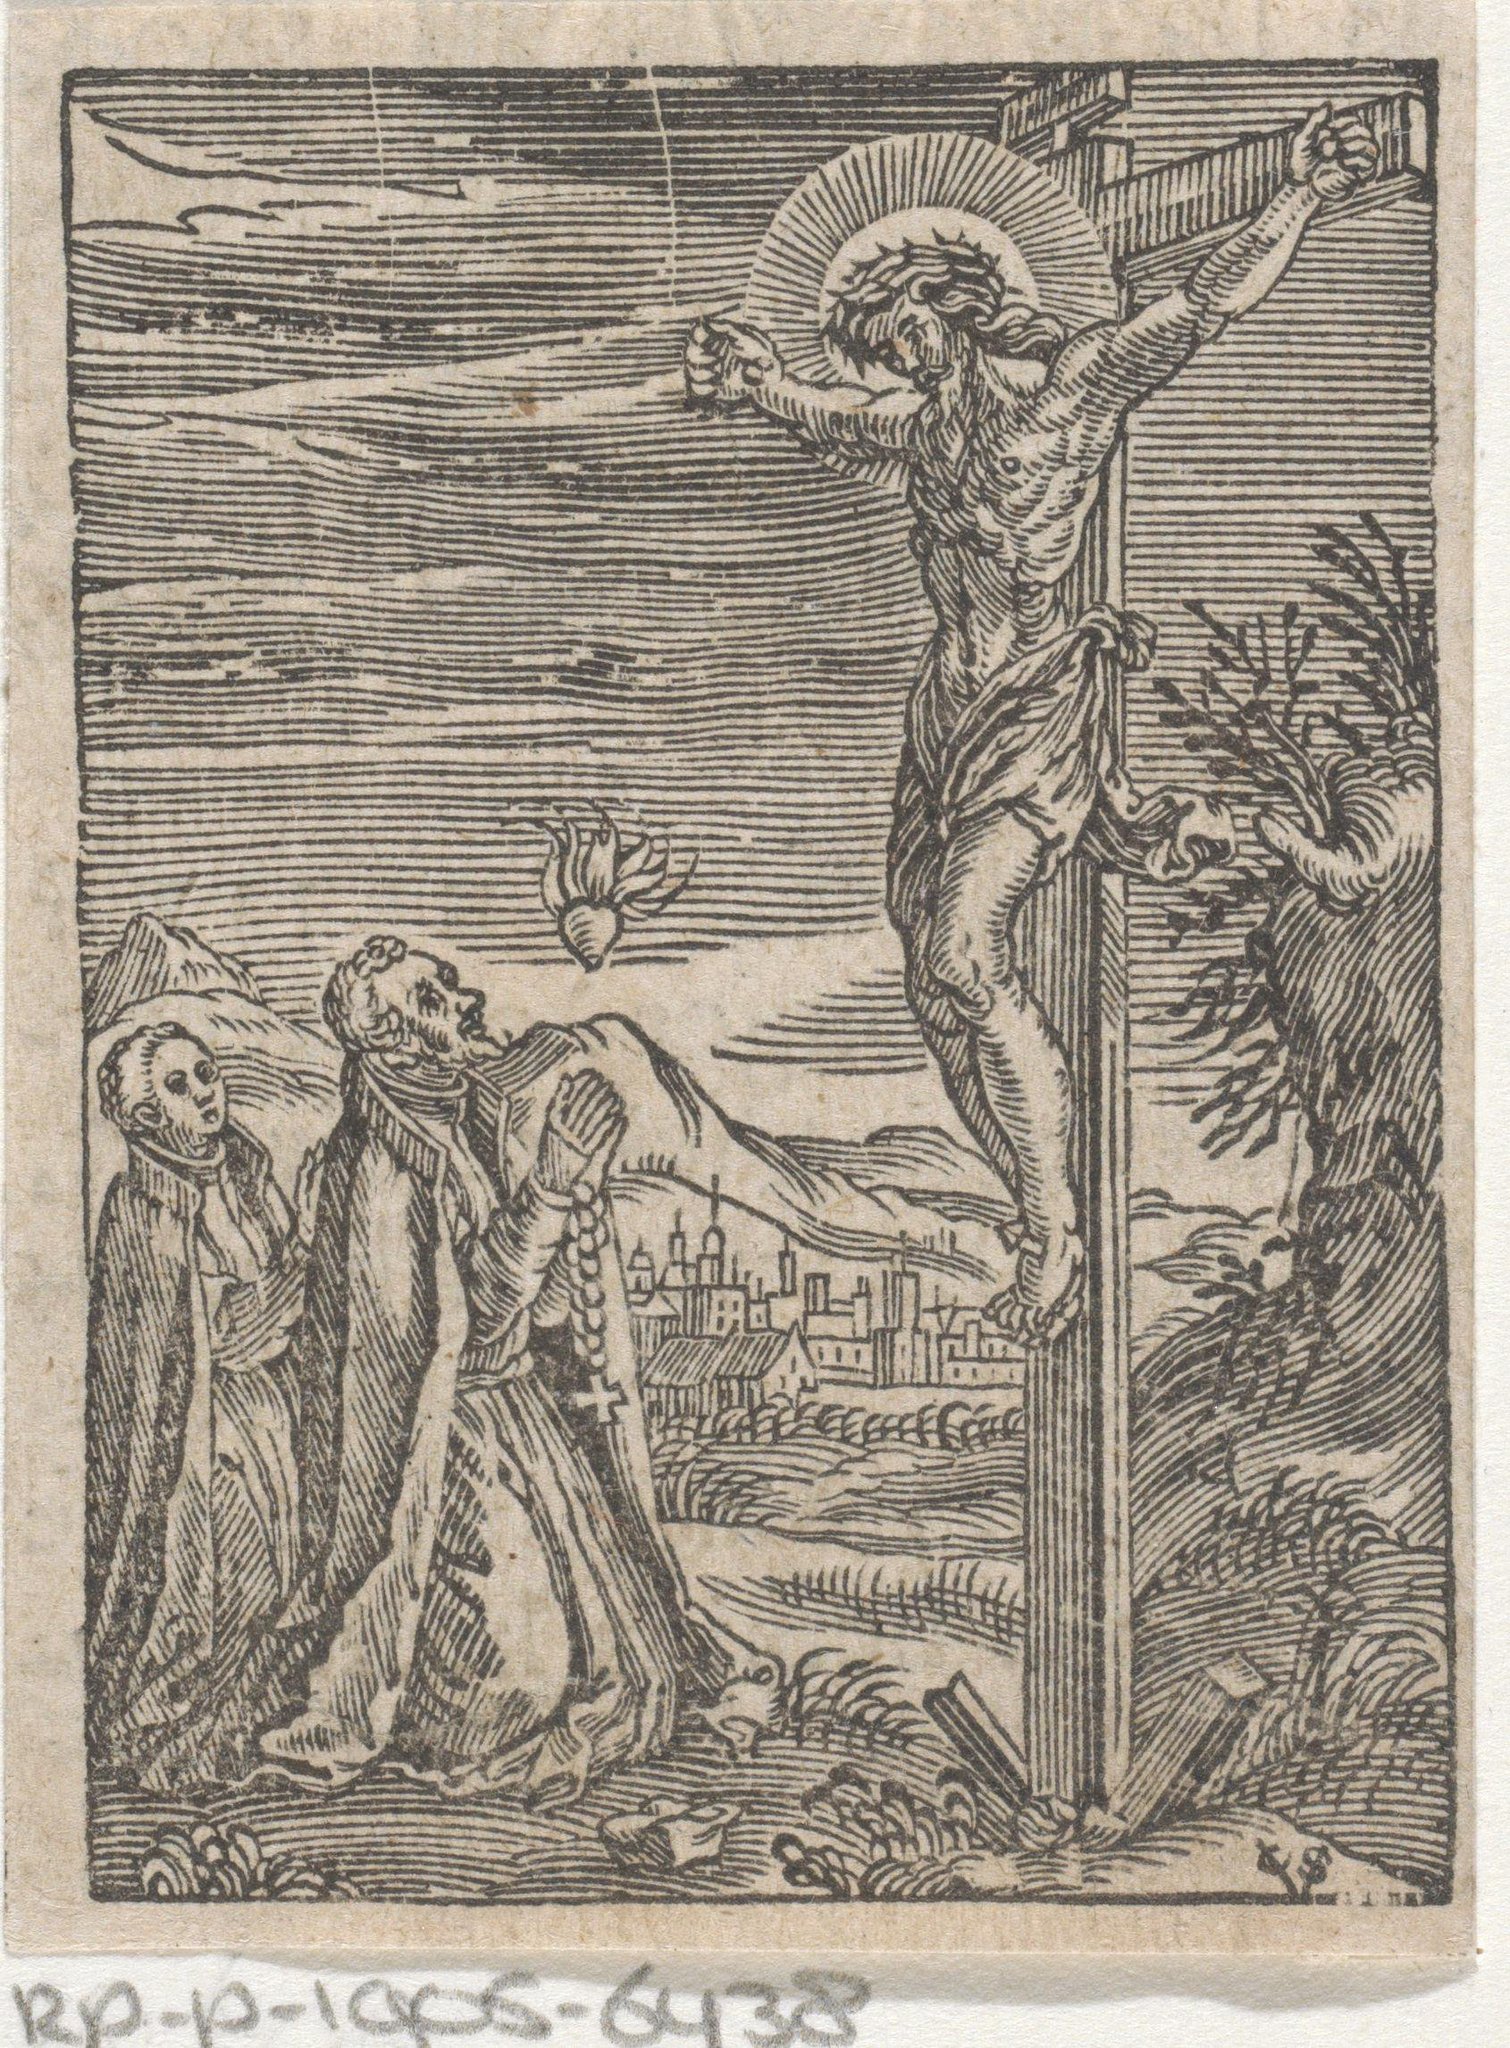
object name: print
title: Christus aan het kruis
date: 1648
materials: paper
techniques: letterpress printing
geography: amsterdam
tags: crucified christ, with particular persons under the cross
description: Prent uit: Sichem, Christoffel van (II). 'tSchat der zielen, dat is: Het geheele leven ons Heeren Iesu Christi. Amsterdam: Pieter Jacobsz. Paets, 1648. Prent uit: Biblia sacra dat is De geheele Heylighe Schrifture bedeylt in 't Out en Nieu Testament. Amsterdam: Pieter Jacobsz. Paets, 1657.